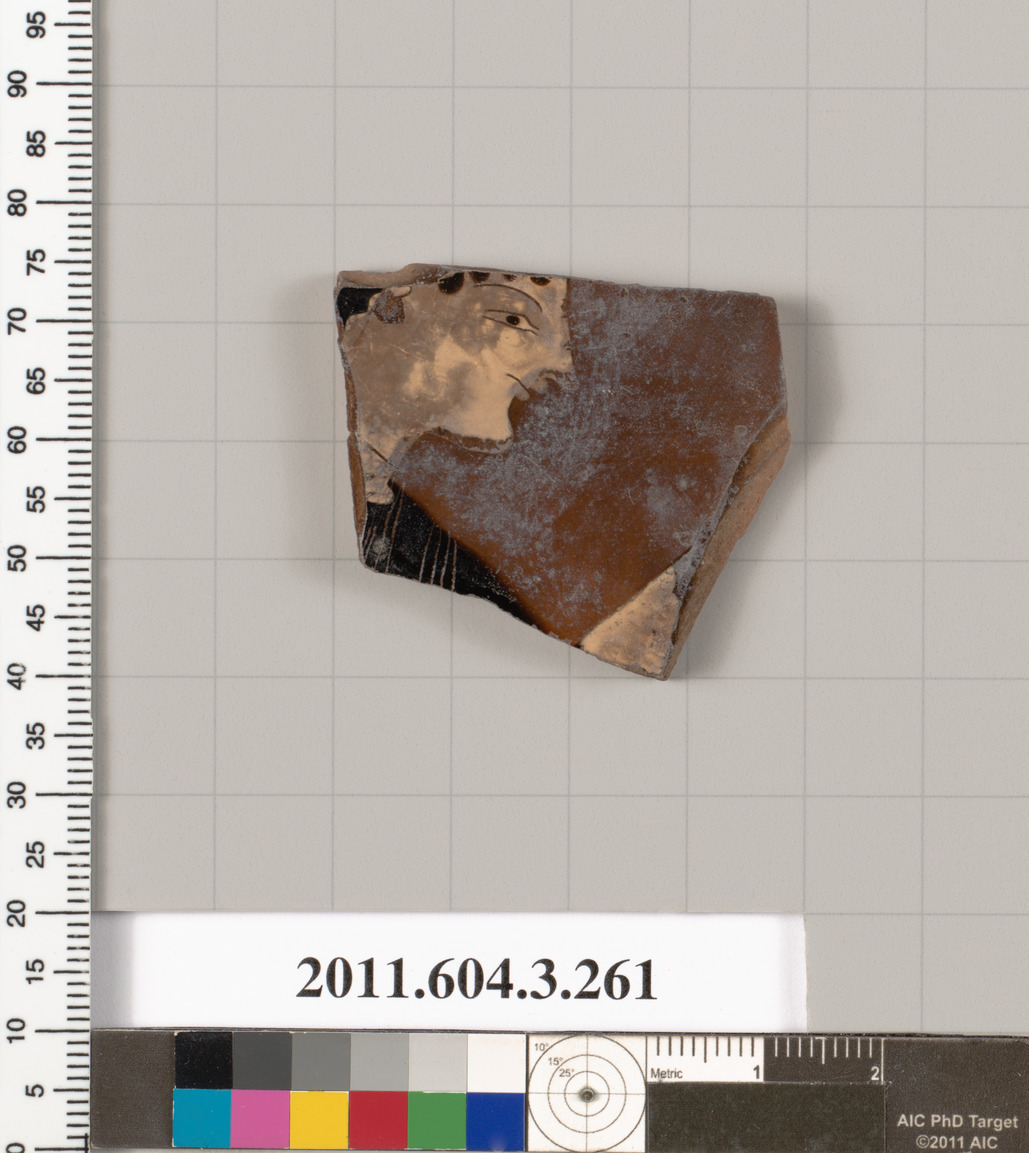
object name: neck amphora fragment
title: Terracotta fragment of a neck-amphora (jar)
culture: greek, attic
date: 530-520 BCE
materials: terracotta